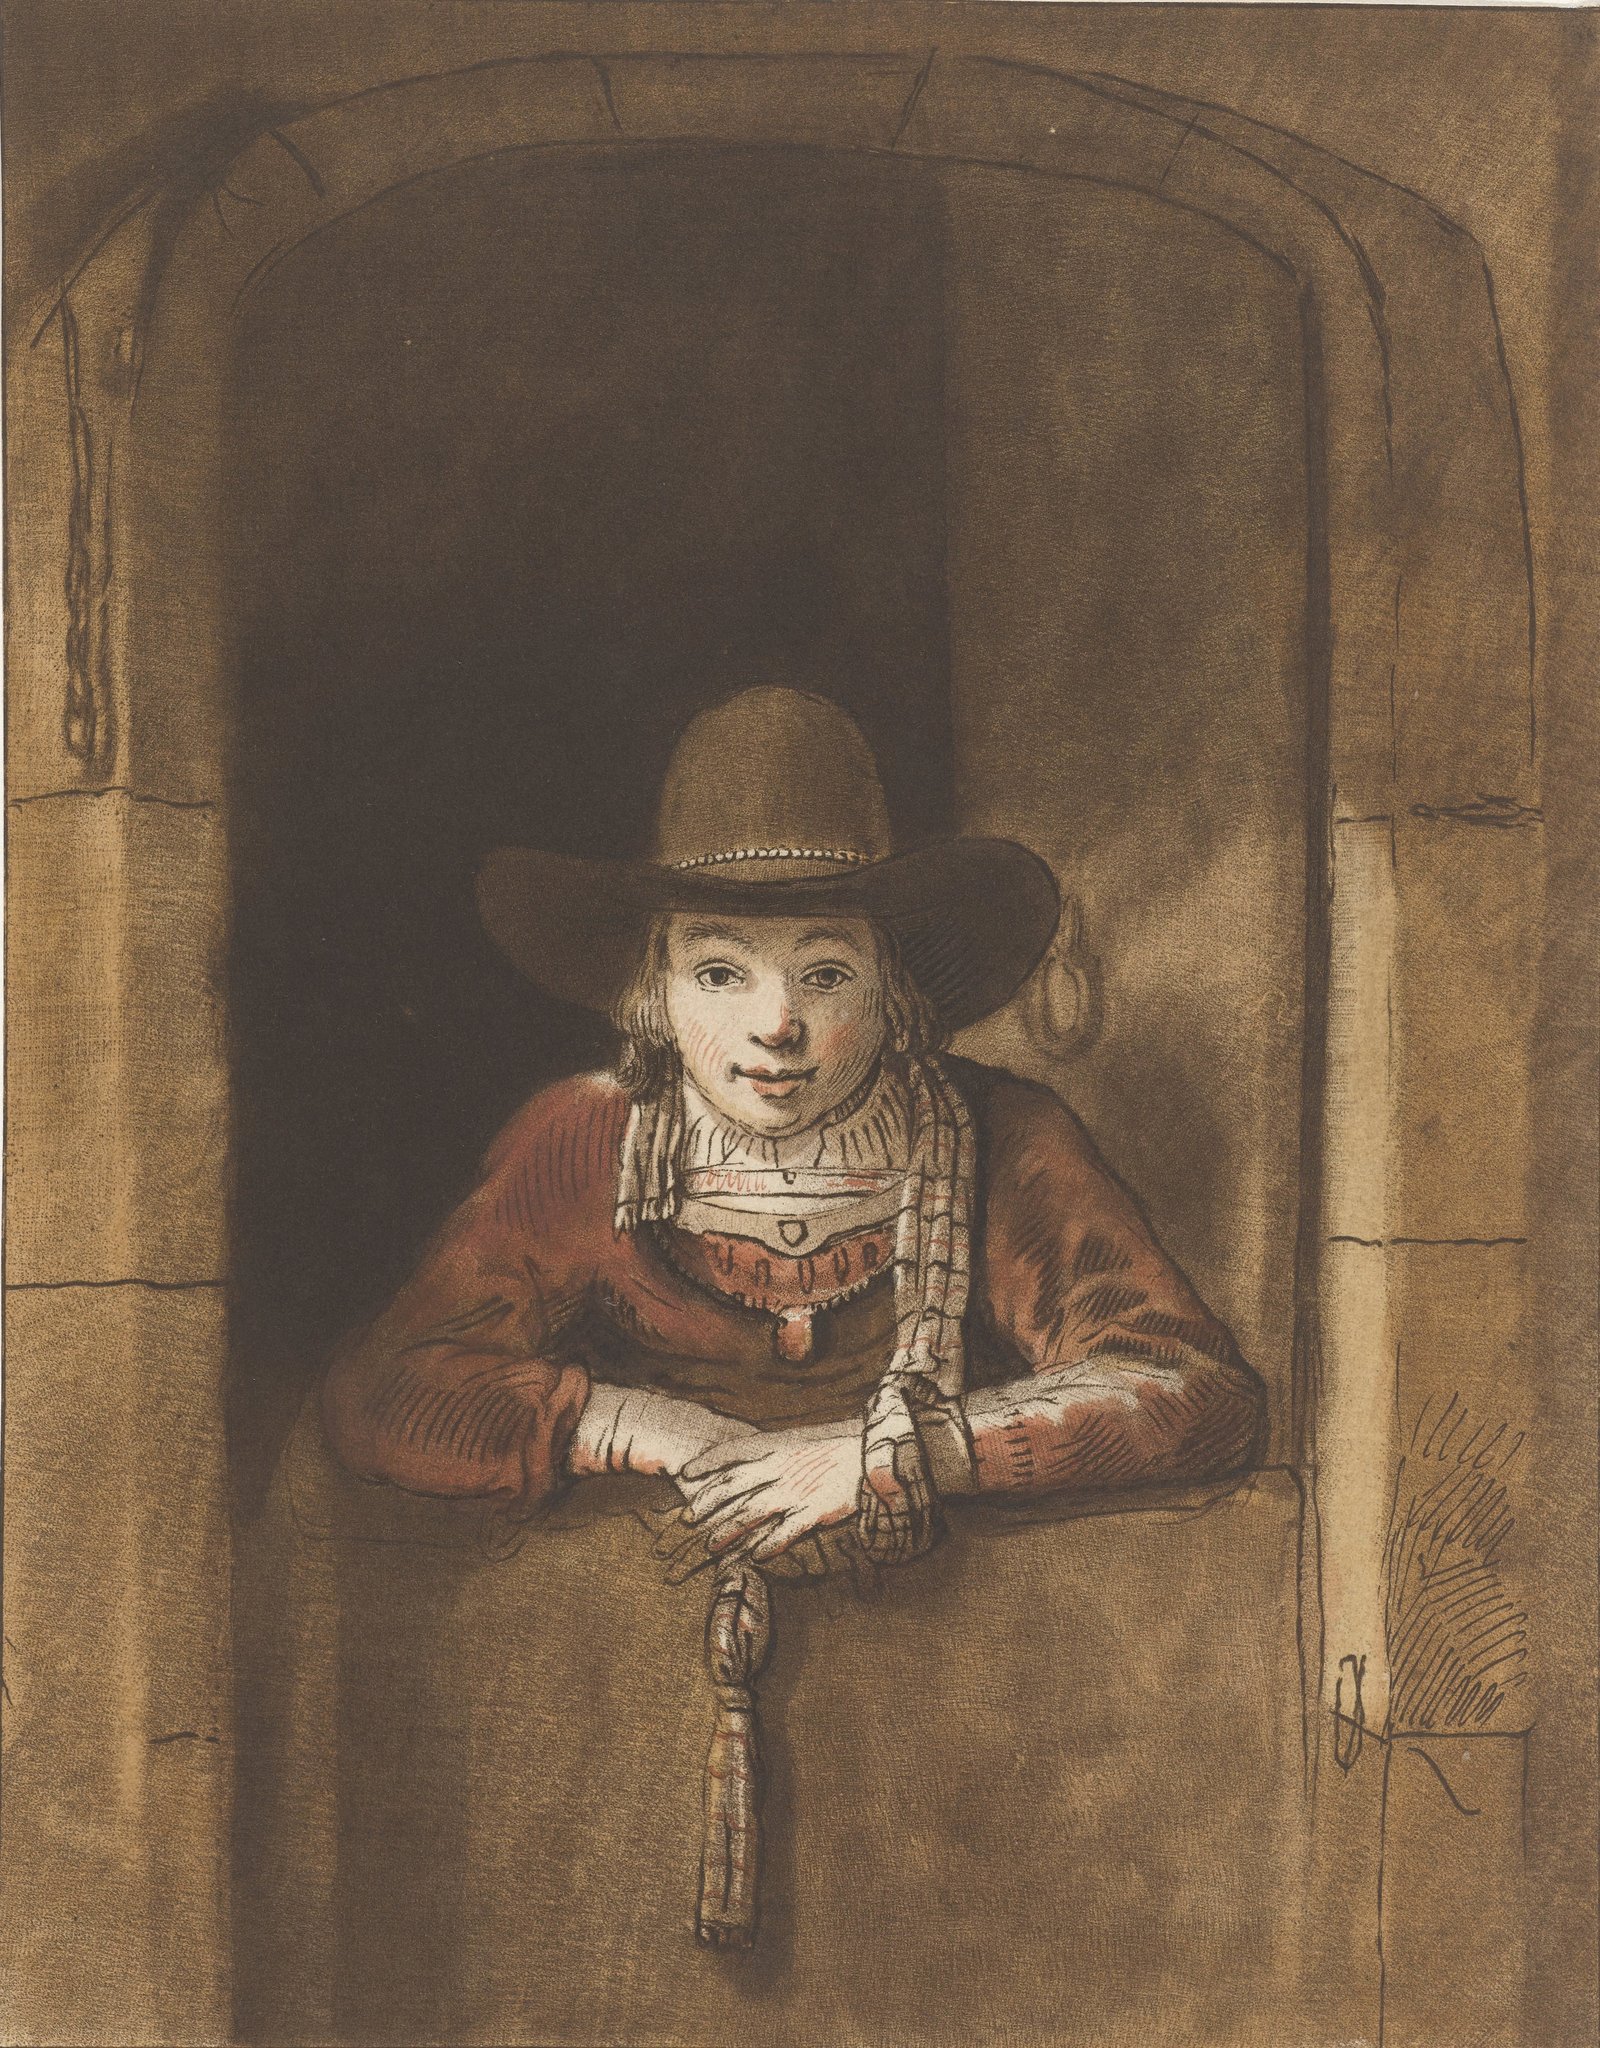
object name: print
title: Jongen leunend over een onderdeur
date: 1763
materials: paper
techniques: etching, hand coloring, roulette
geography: amsterdam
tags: boy (child between toddler and youth), divided door, upper part opened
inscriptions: collector's mark: Lugt 2725, collector's mark: Lugt 12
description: Een jongen, met een hoed op zijn hoofd, leunt over een onderdeur.